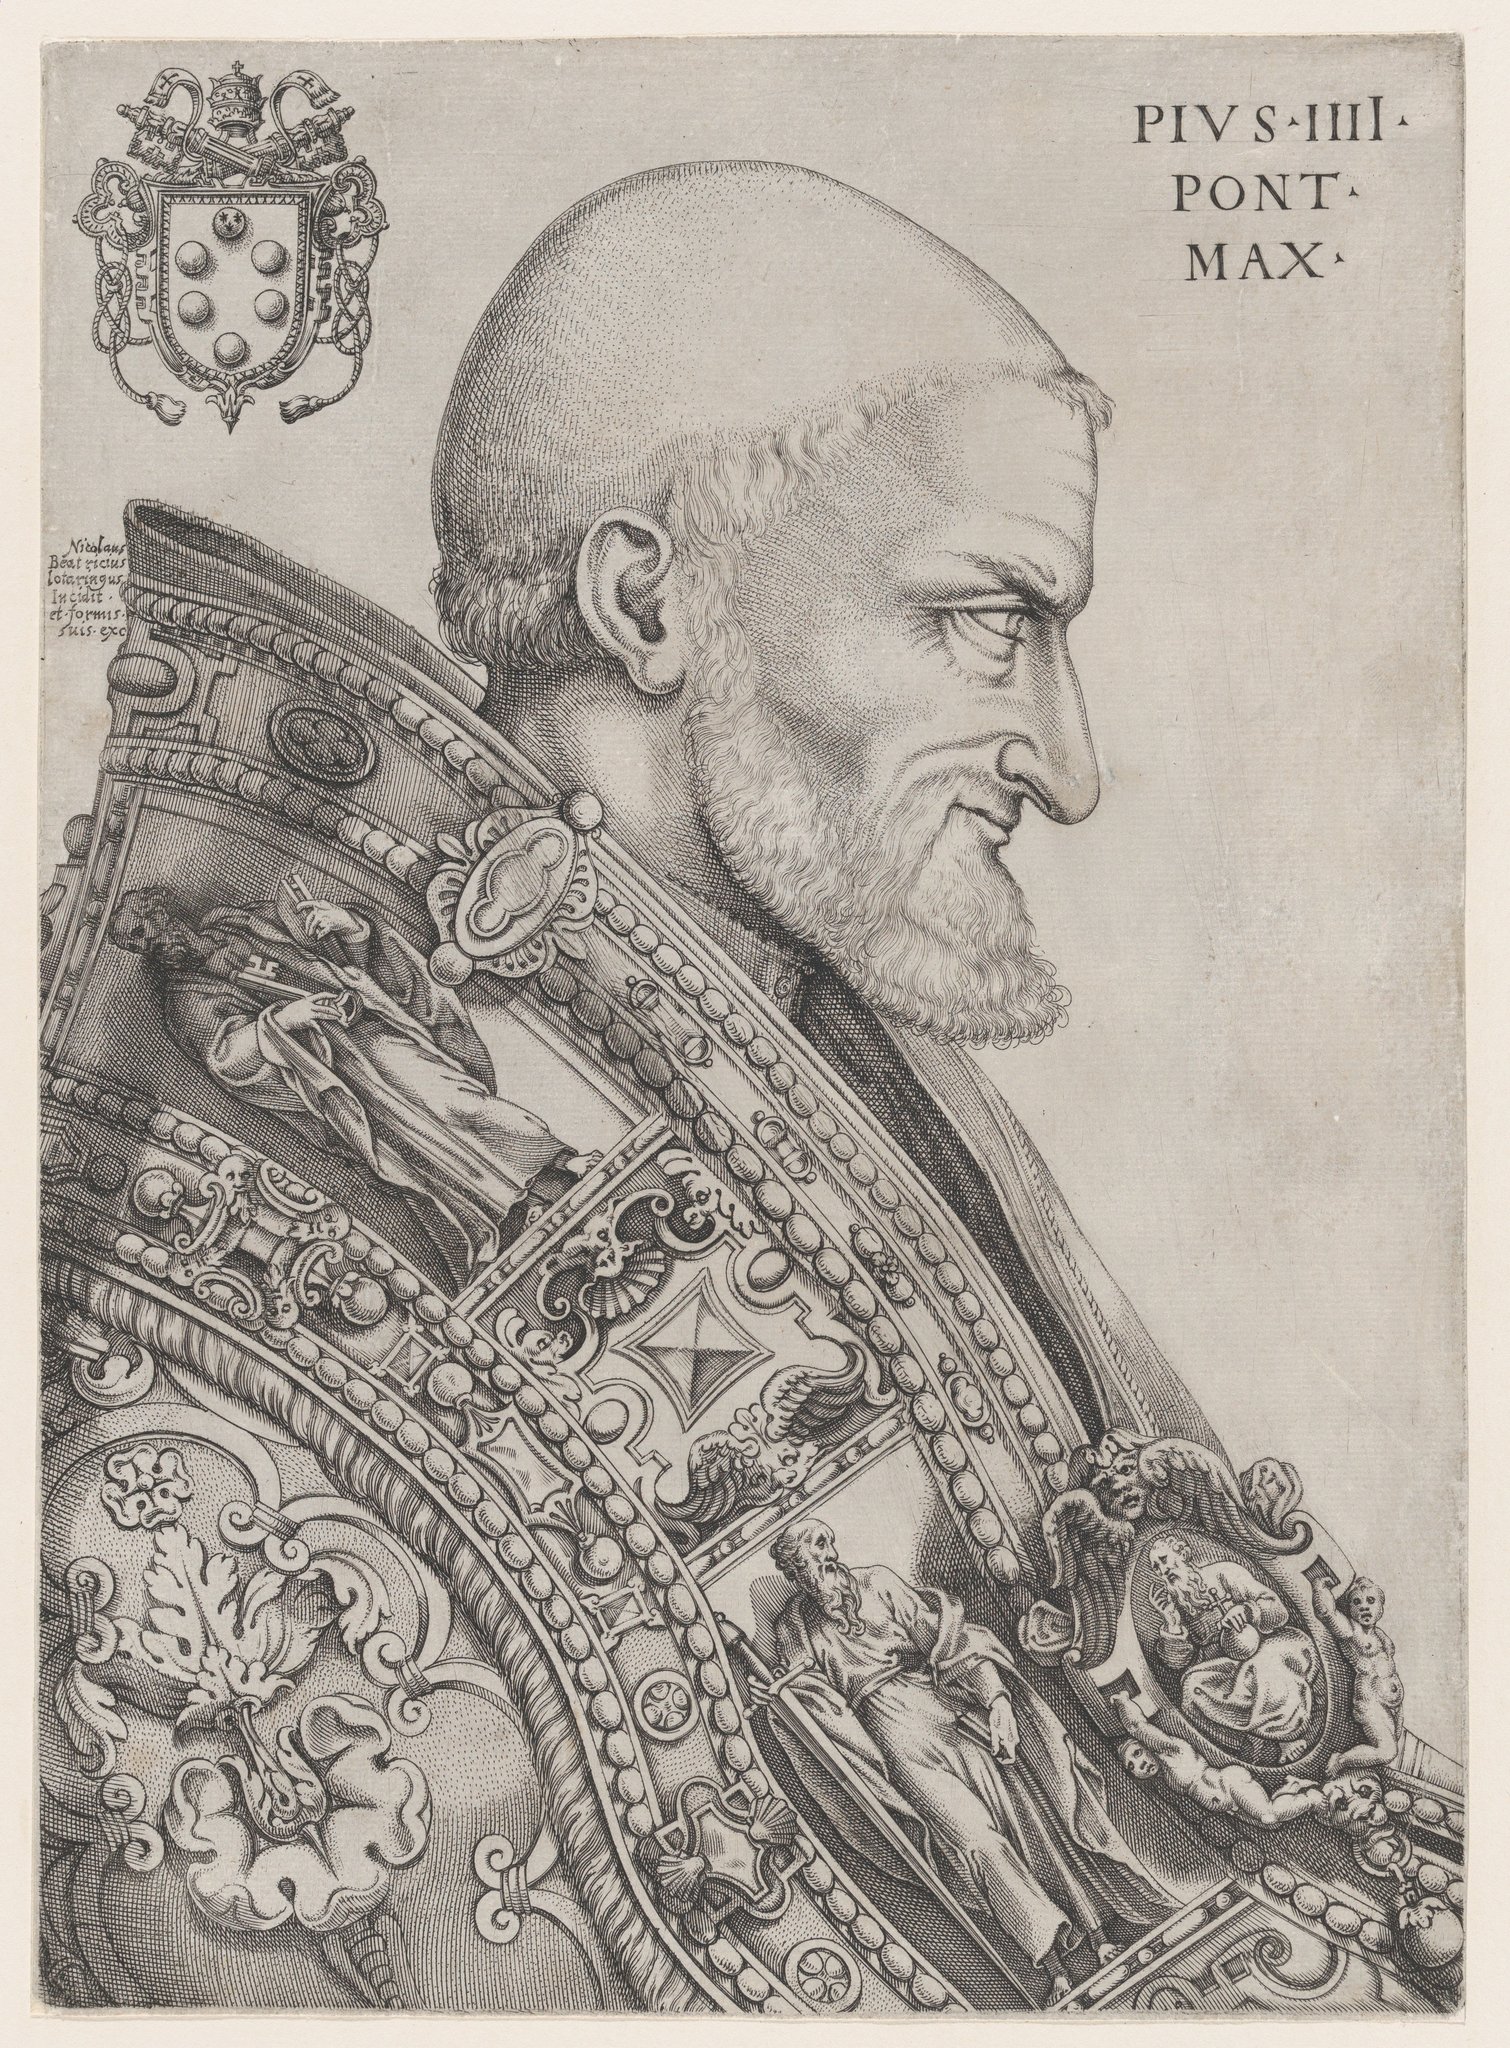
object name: print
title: Portrait of Pope Pius IV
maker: nicolas beatrizet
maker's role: artist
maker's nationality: french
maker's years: 1515-1566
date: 1534-1566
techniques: engraving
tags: men,profiles,popes,coat of arms